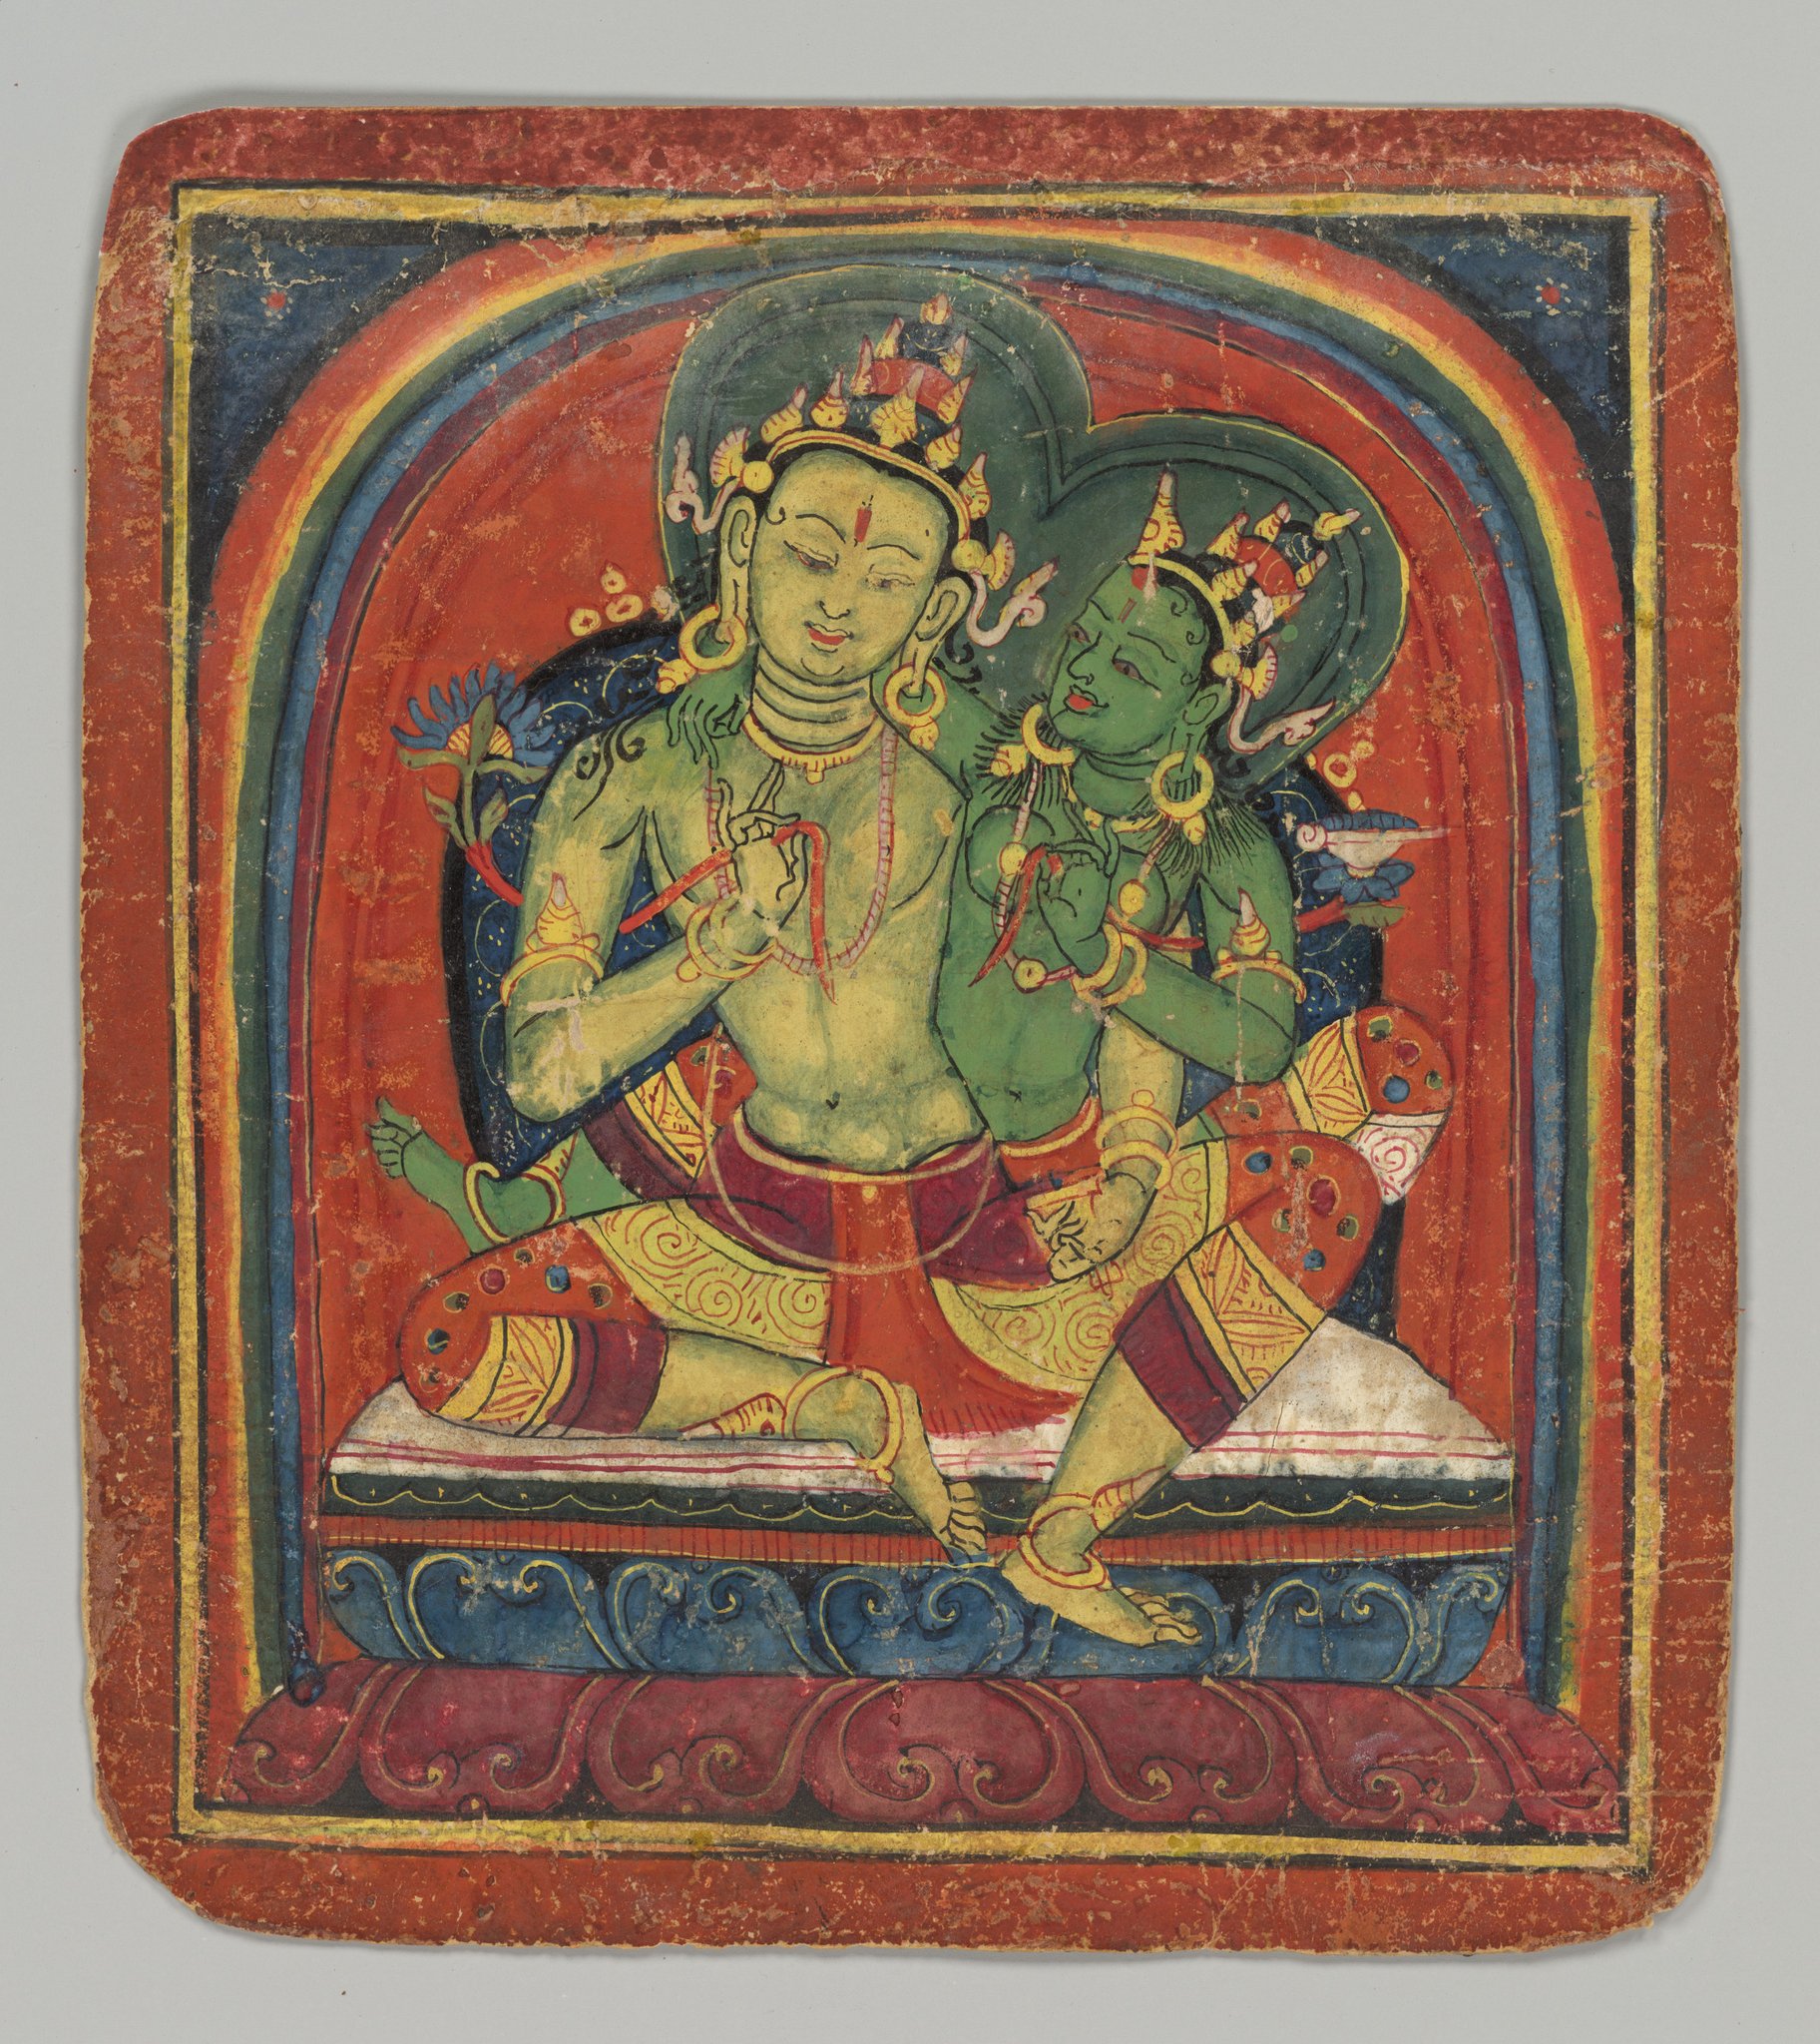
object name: initiation card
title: Initiation Card (Tsakalis): Manjushri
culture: tibetan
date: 1401-1433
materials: paper, watercolor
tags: manjushri